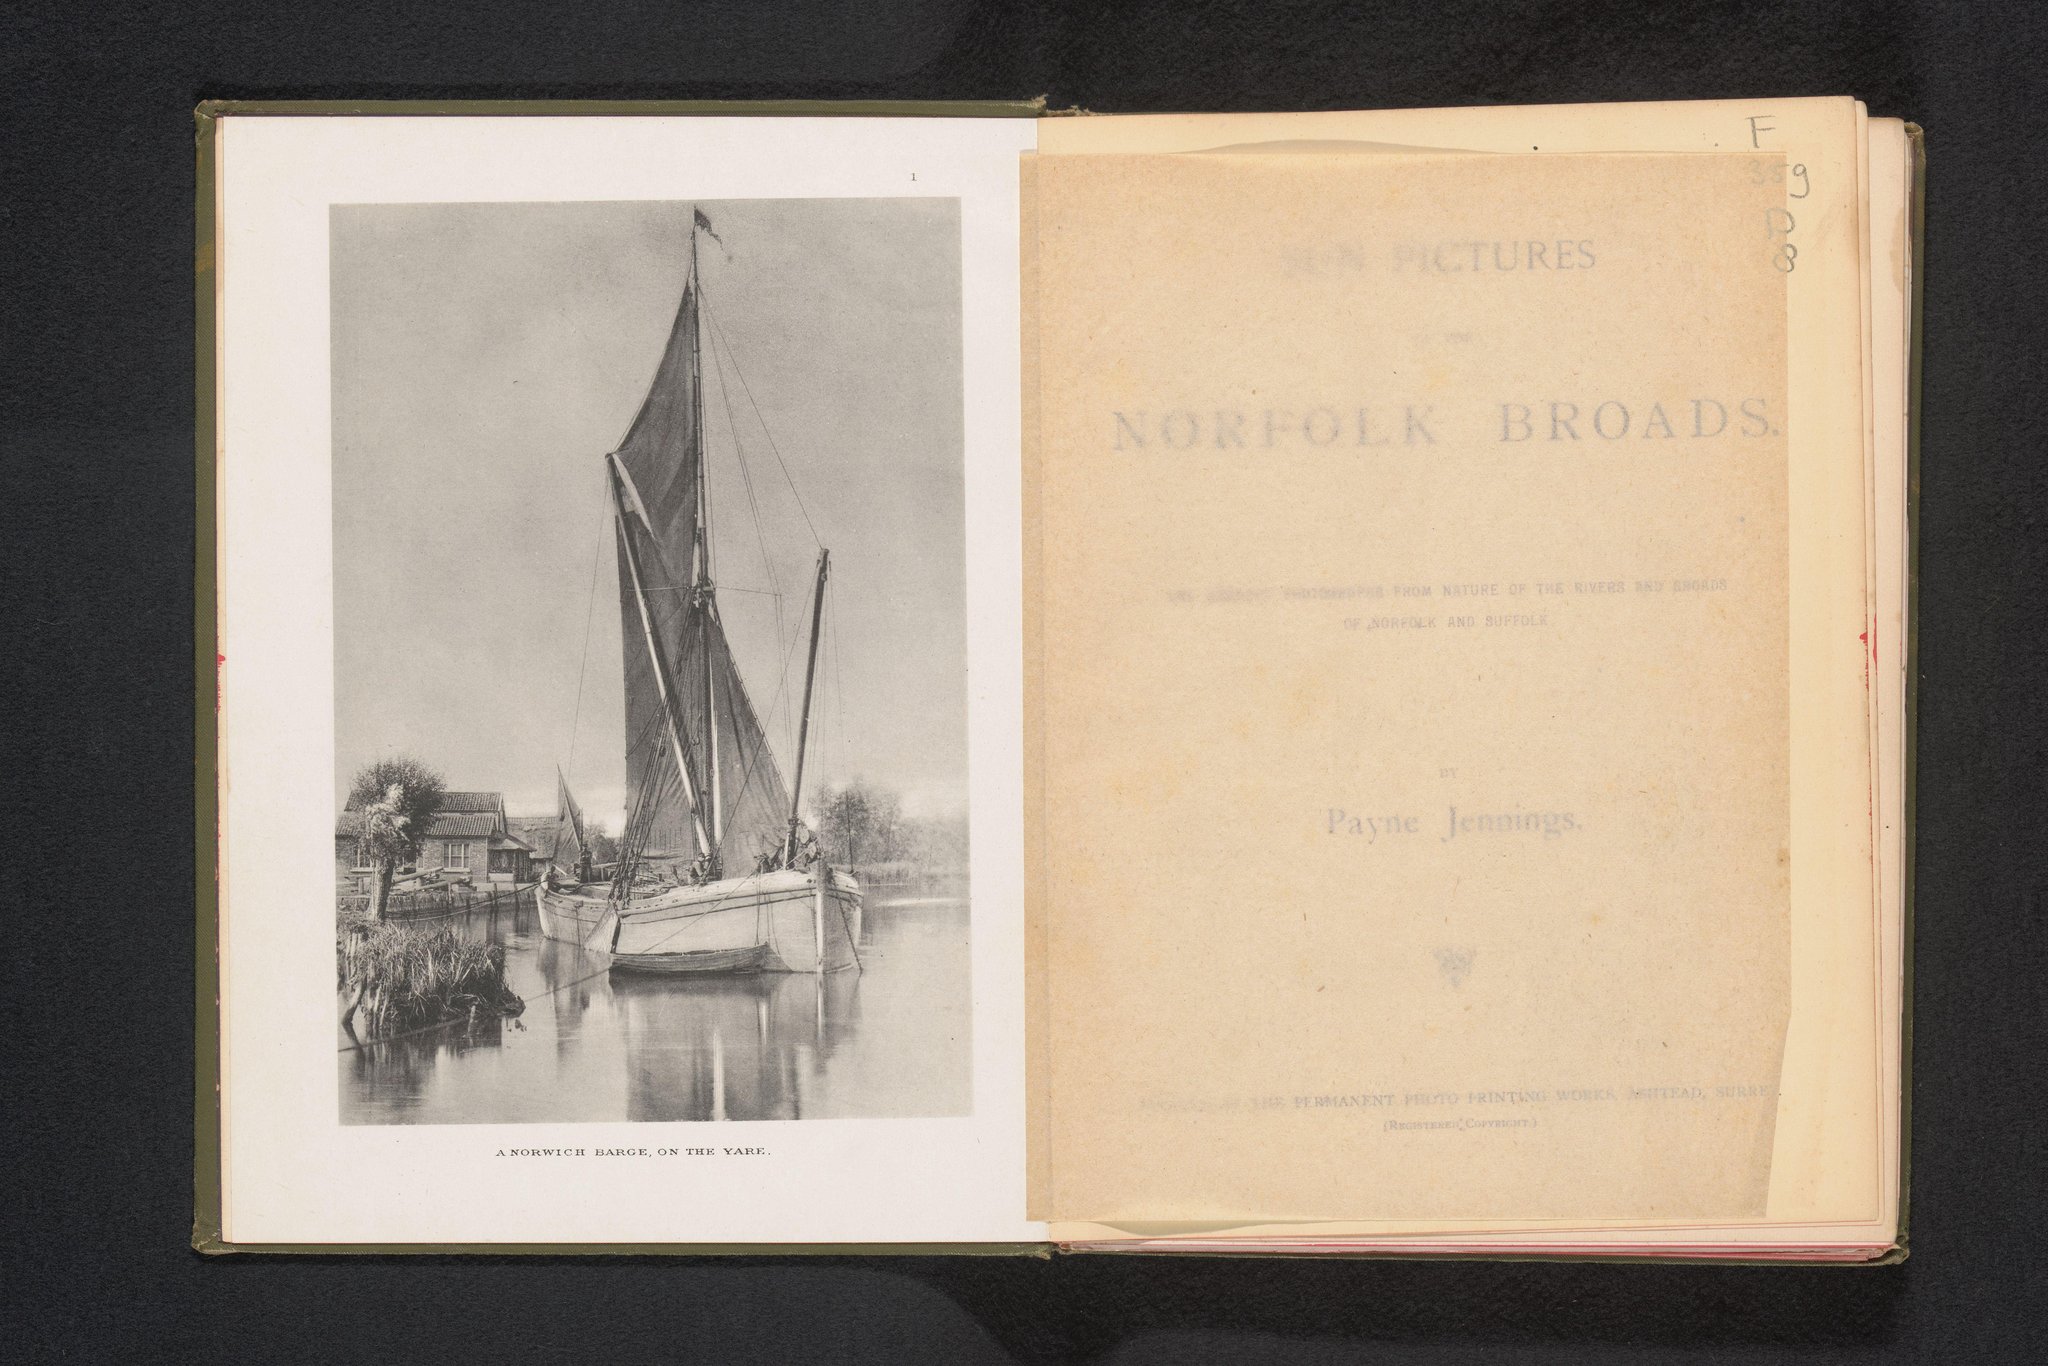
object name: photomechanical print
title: A Norwich barge, on the yare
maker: john payne jennings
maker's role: fotograaf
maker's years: 1843-1926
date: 1886-1891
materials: paper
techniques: photograph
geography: surrey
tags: sailing-ship, sailing-boat, river, landscapes with waters, waterscapes, seascapes (in the temperate zone)